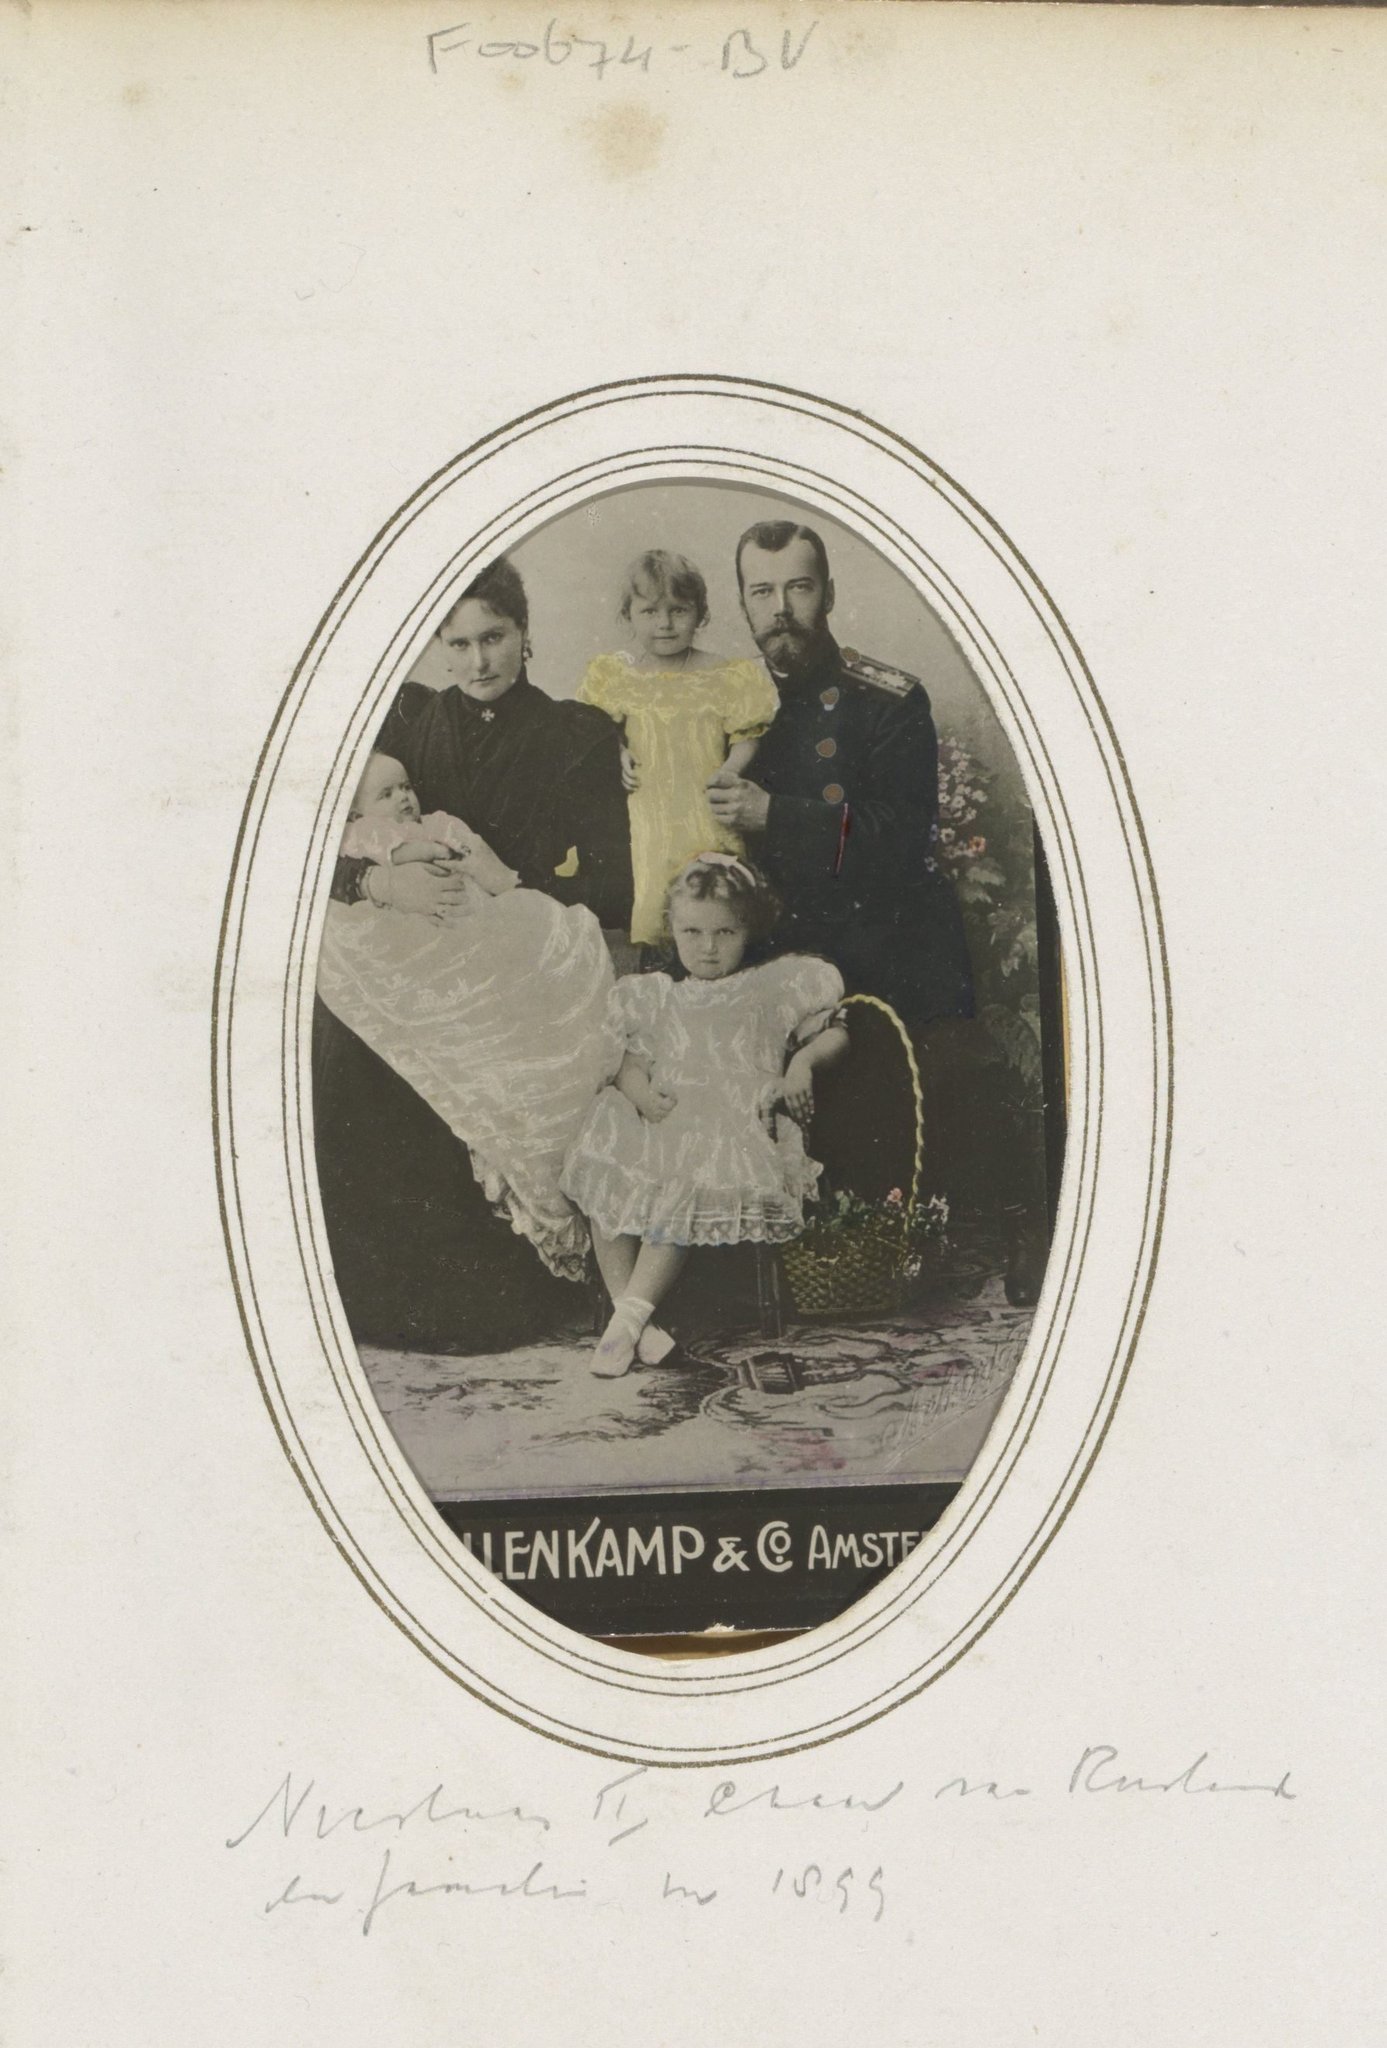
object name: photograph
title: Groepsportret van tsaar Nicolaas II van Rusland en zijn gezin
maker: Anonymous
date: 1899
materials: cardboard, paper, photographic support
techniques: collodion silver print, coloring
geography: amsterdam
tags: family group, especially parents with their child(ren), historical persons, ruler, sovereign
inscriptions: address: ‘H. Hollenkamp & Co. Amsterdam’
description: Onderdeel van Fotoalbum met 123 cartes-de-visite van leden van Europese vorstenhuizen, politici en bekende personen.